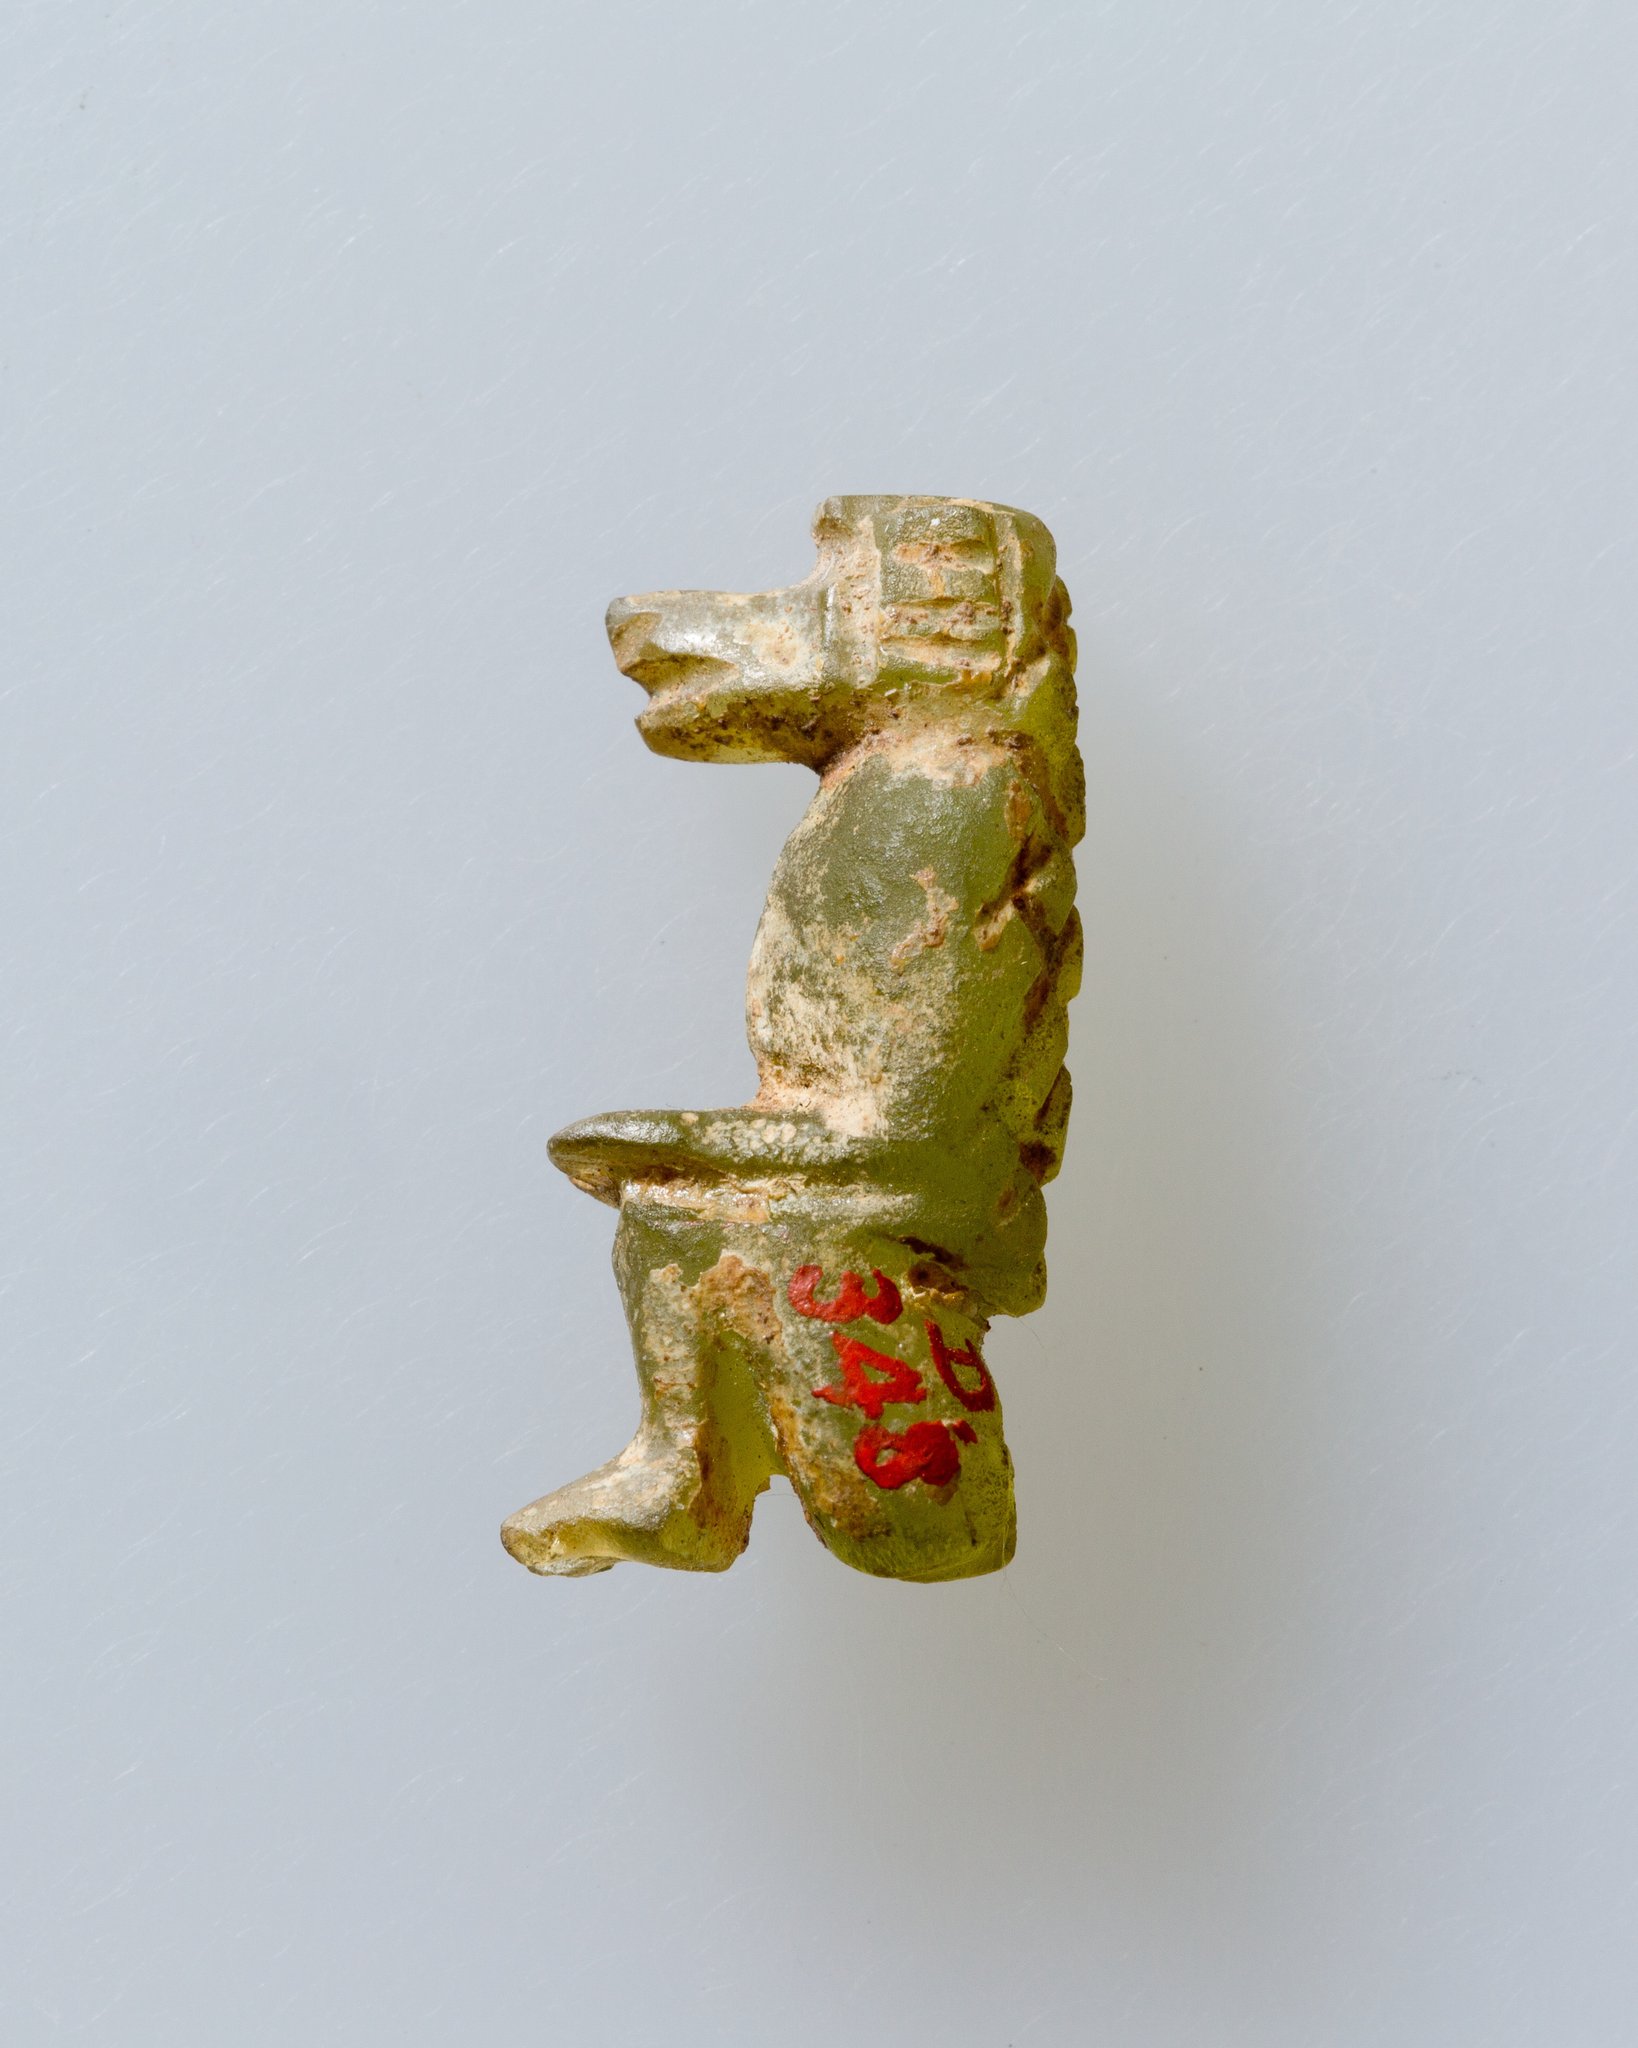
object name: amulet, baboon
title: Baboon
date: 200 BCE-200 CE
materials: stone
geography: egypt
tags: baboons